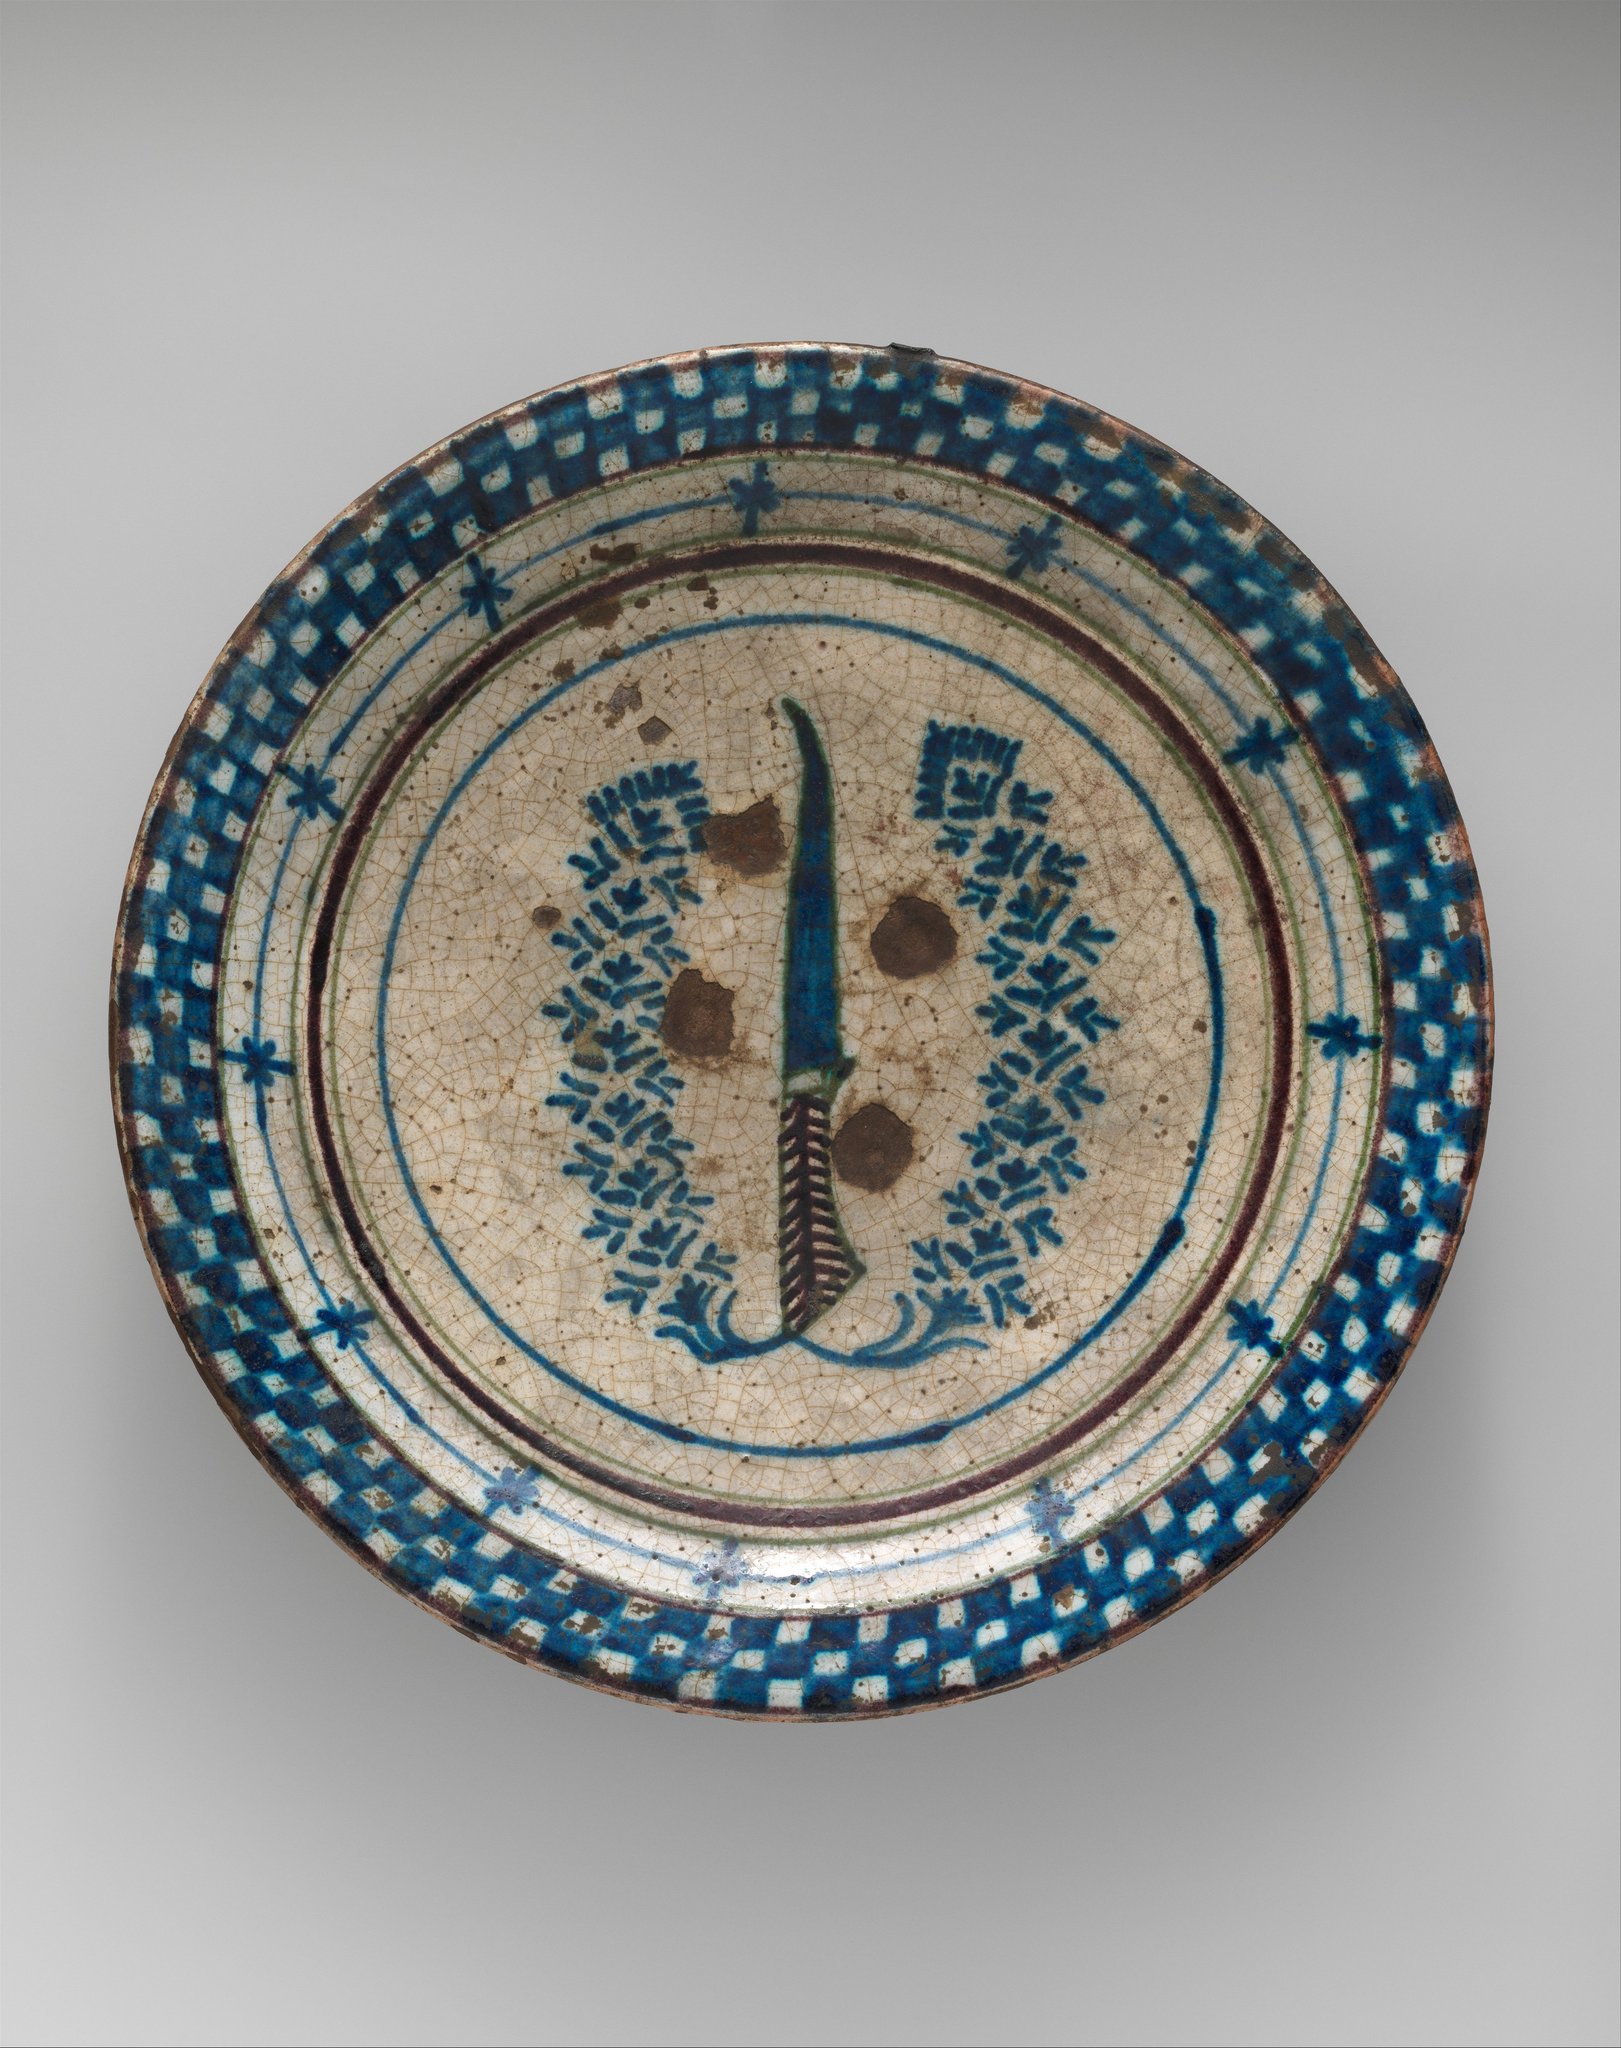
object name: dish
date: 1701-1800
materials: earthenware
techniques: glazing, painting, underglaze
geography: uzbekistan